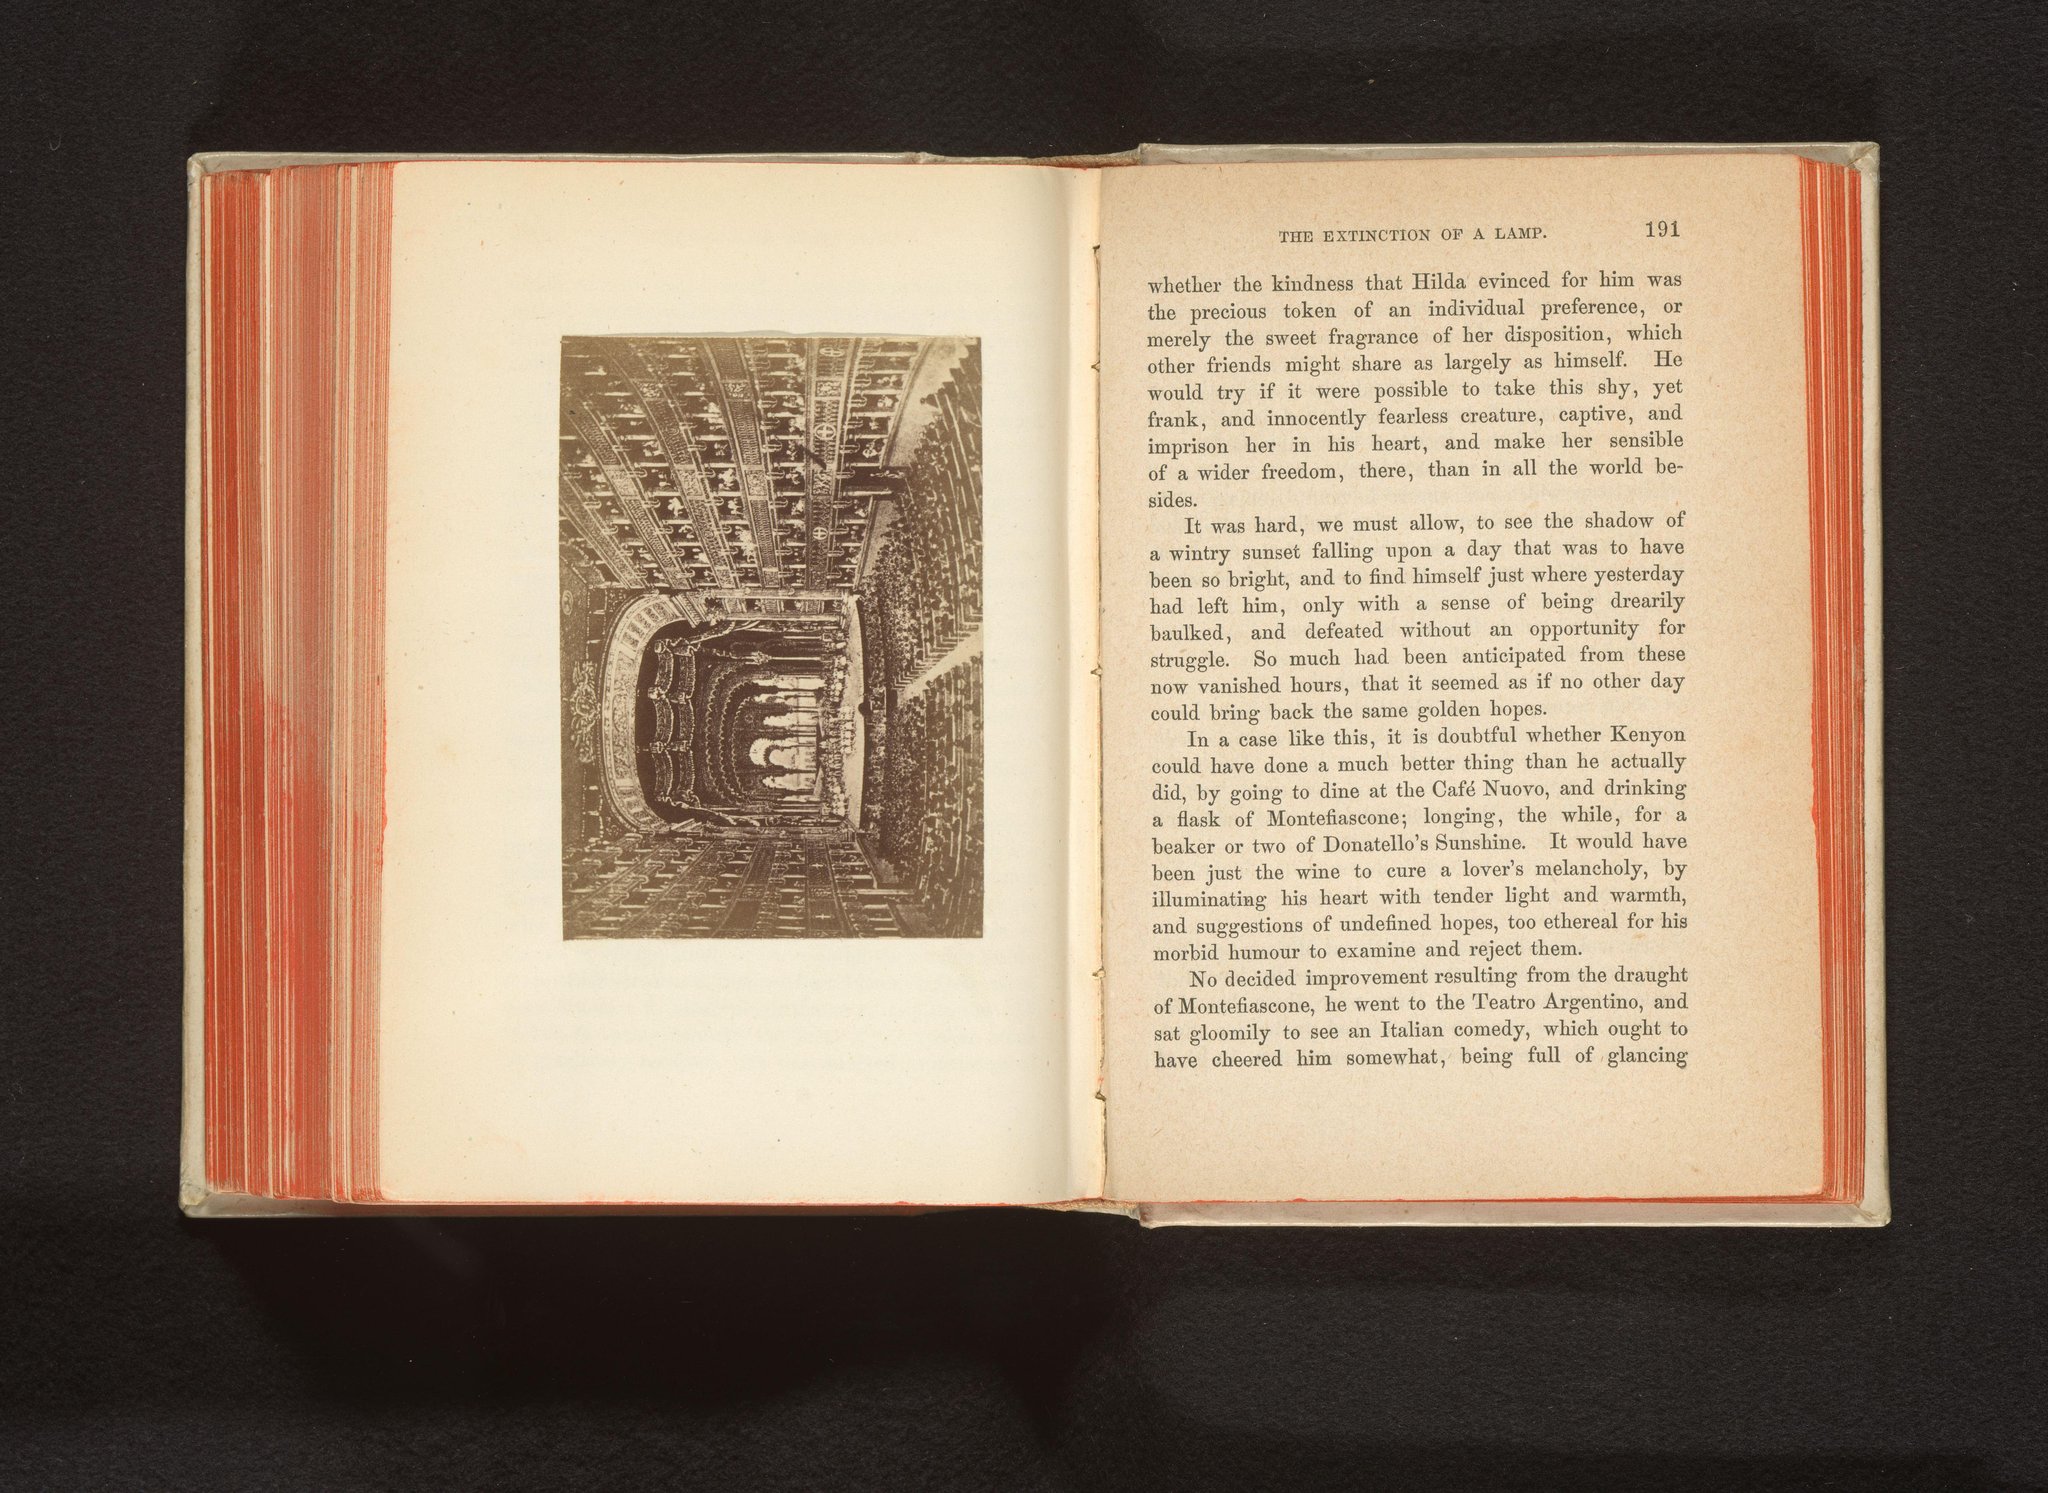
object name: reproduction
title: Fotoreproductie van vermoedelijk een tekening van een theater in Rome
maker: Anonymous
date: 1850-1860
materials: photographic support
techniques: albumen print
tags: theatre (building)